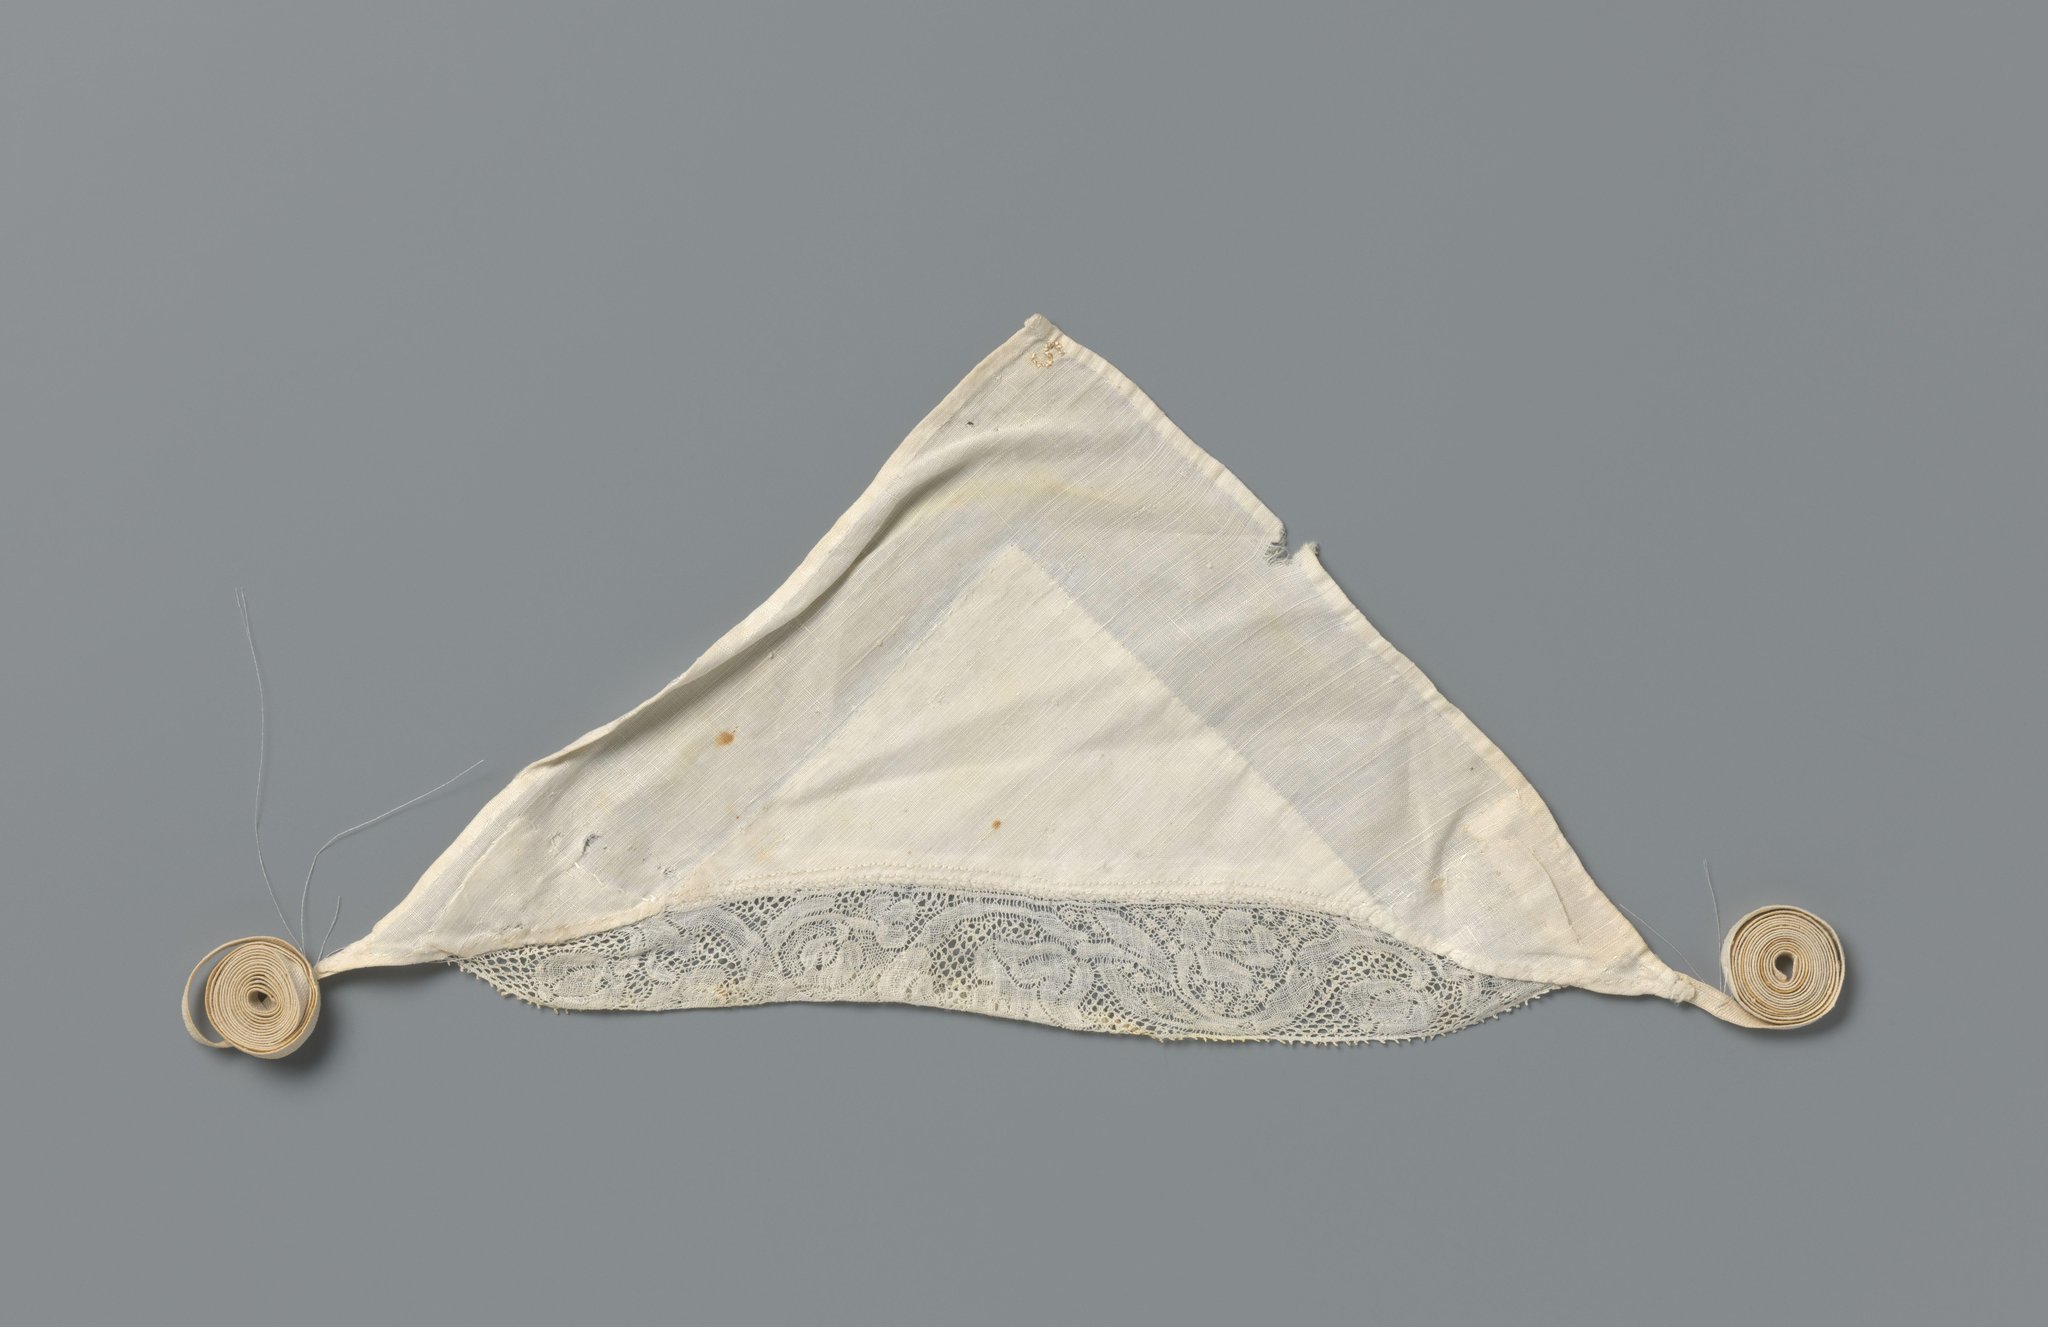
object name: childrenswear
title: Fontaneldoek van wit linnen met kant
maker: Anonymous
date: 1800-1900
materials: linen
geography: schiermonnikoog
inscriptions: number: ‘A.44.’, inscription: ‘S’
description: Een driekant hoofddoekje met kanten rand (deel van een Fries Kinderkostuum). Afkomstig uit Schiermonnikoog.